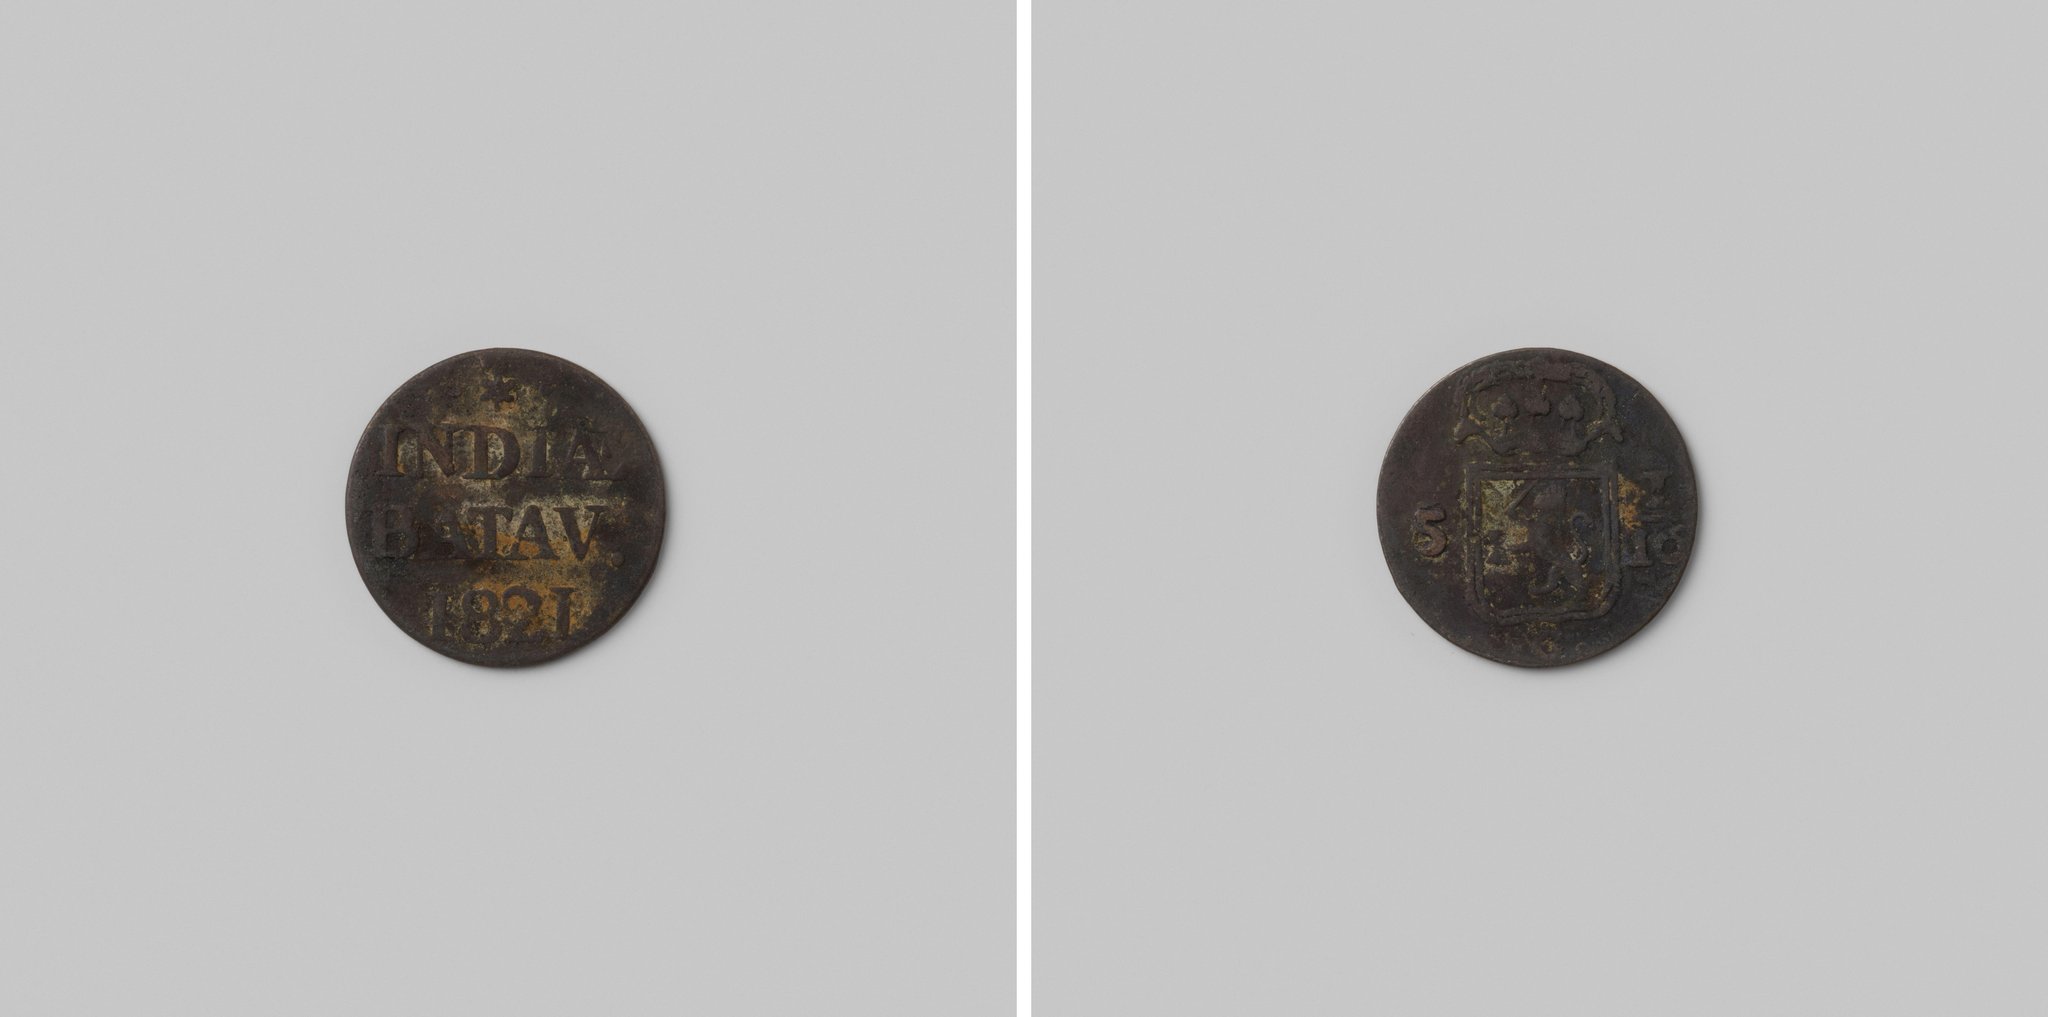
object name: coin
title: Koperen VOC-munt uit 1821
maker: Anonymous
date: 1821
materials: copper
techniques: striking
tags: dutch east indies, the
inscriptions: inscription: ‘5 I 16 C’, inscription: ‘B.A. Seaby, LTD. / Numismatists, / 65, Great Portland Street, / London, W.1’, inscription: ‘* INDIAE / BATAV. / 1821’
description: Koperen VOC-muntje uit 1821 uit Nederlands-Indië. Voorzijde: opschrift. Keerzijde: wapen met leeuw erin, links ervan een 5 en rechts ervan een I, 16, eronder een C of G. Het muntje zit in een vierkant envelopje met opschrift.